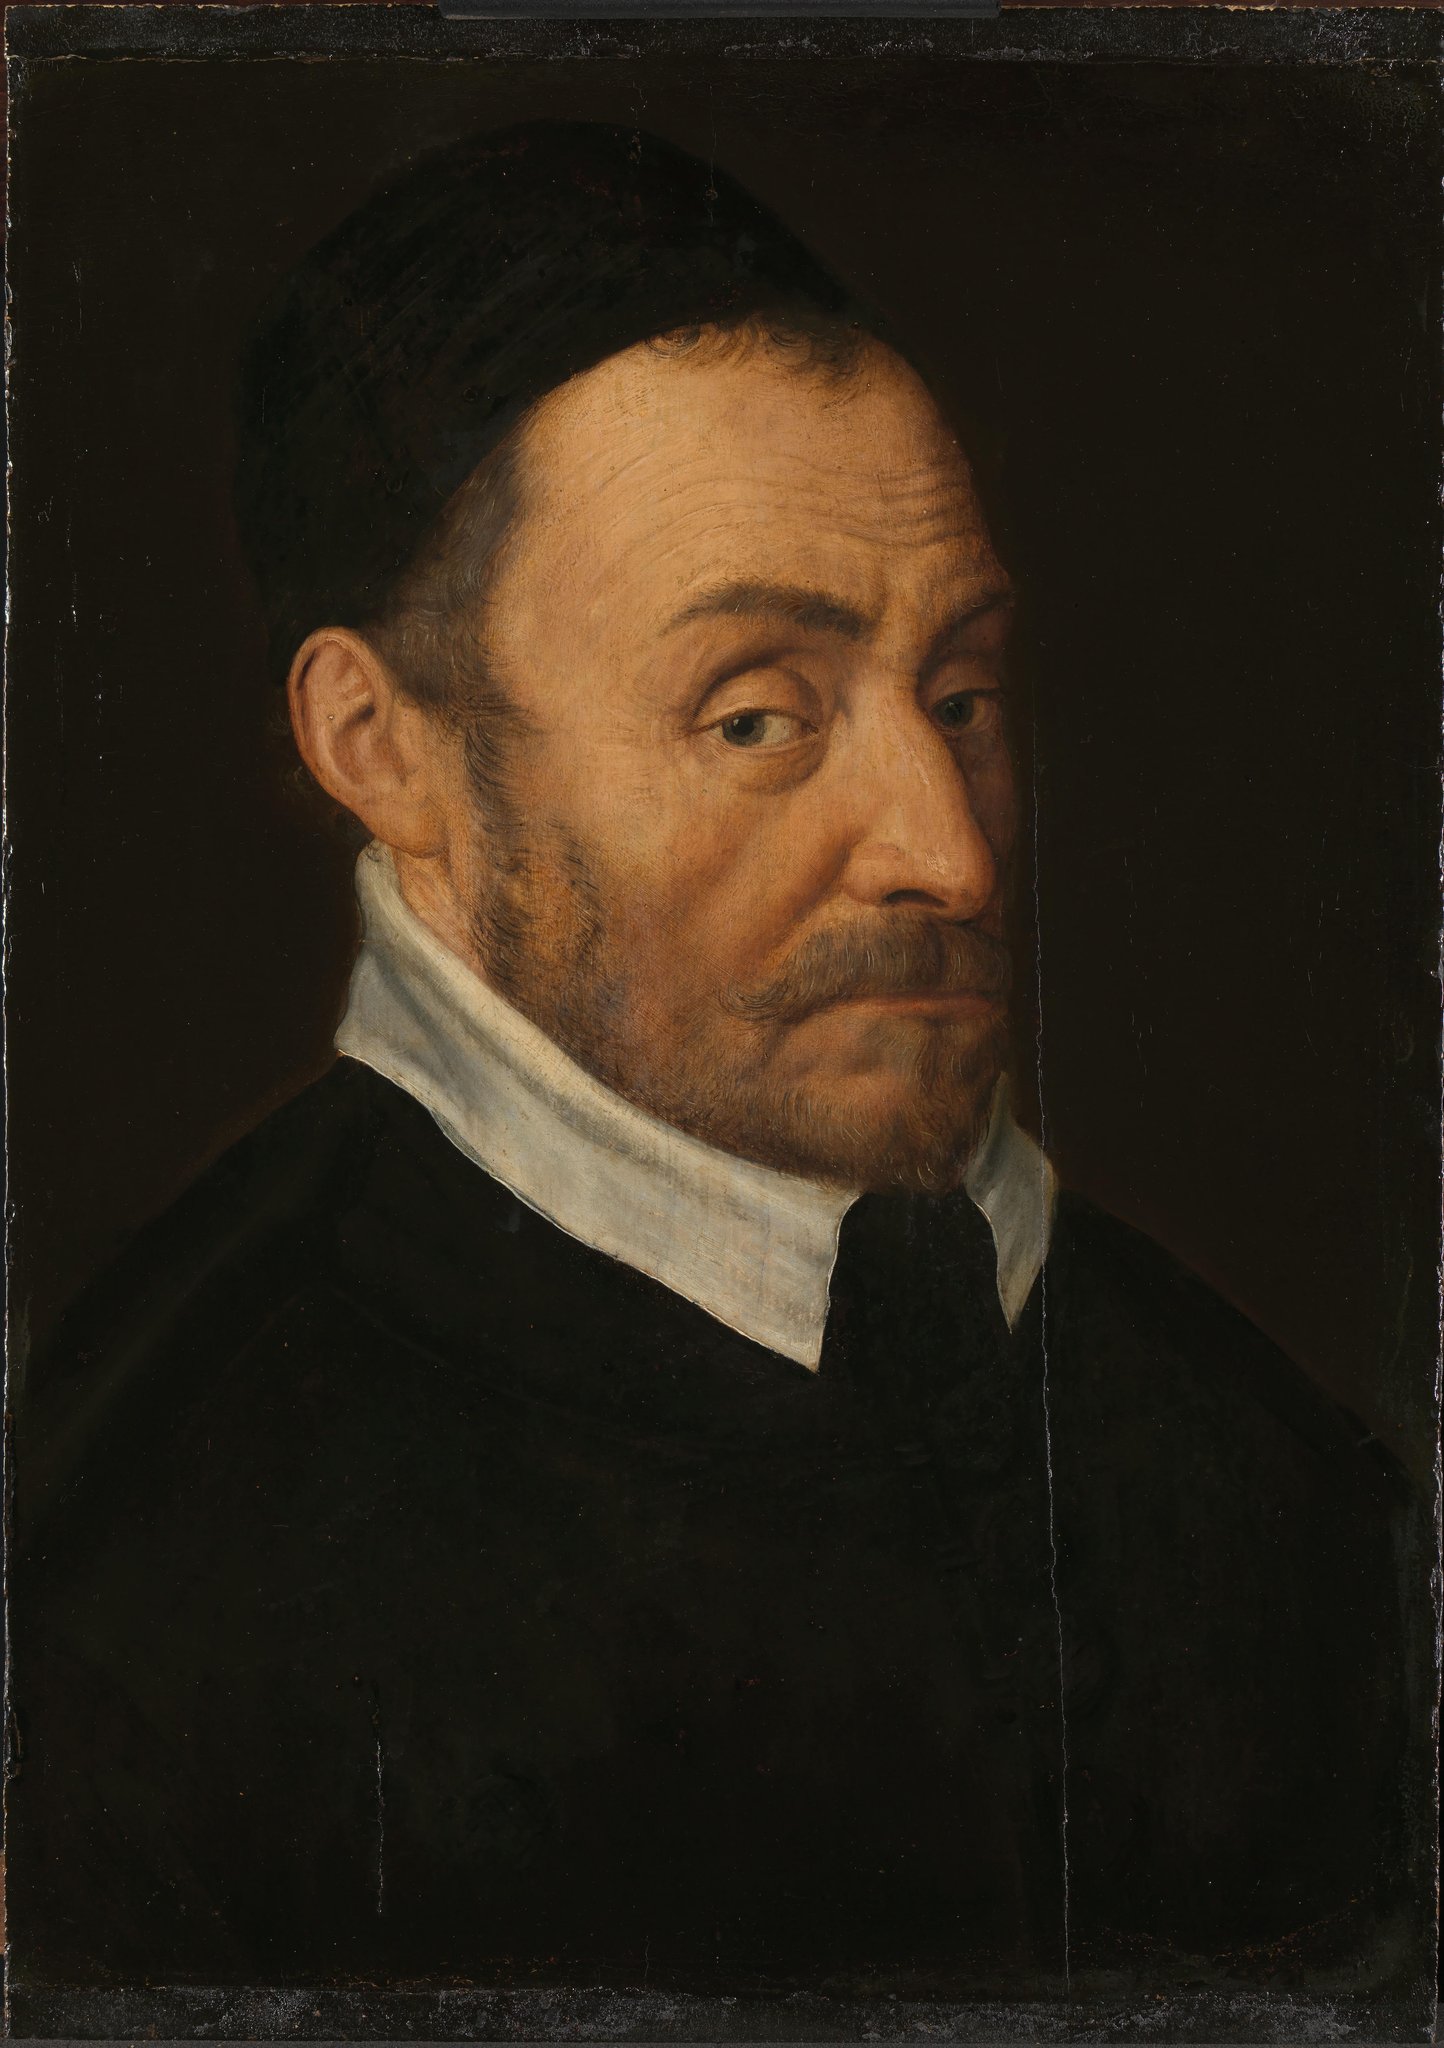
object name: painting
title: Portrait of William I. Prince of Orange, called William the Silent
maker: dirck barendsz.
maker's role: draughtsman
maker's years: 1534-1592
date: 1582-1592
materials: oil, panel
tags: delft, william i (prince of orange), historical persons, ruler, sovereign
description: Portret van Willem I, graaf van Nassau, prins van Oranje.